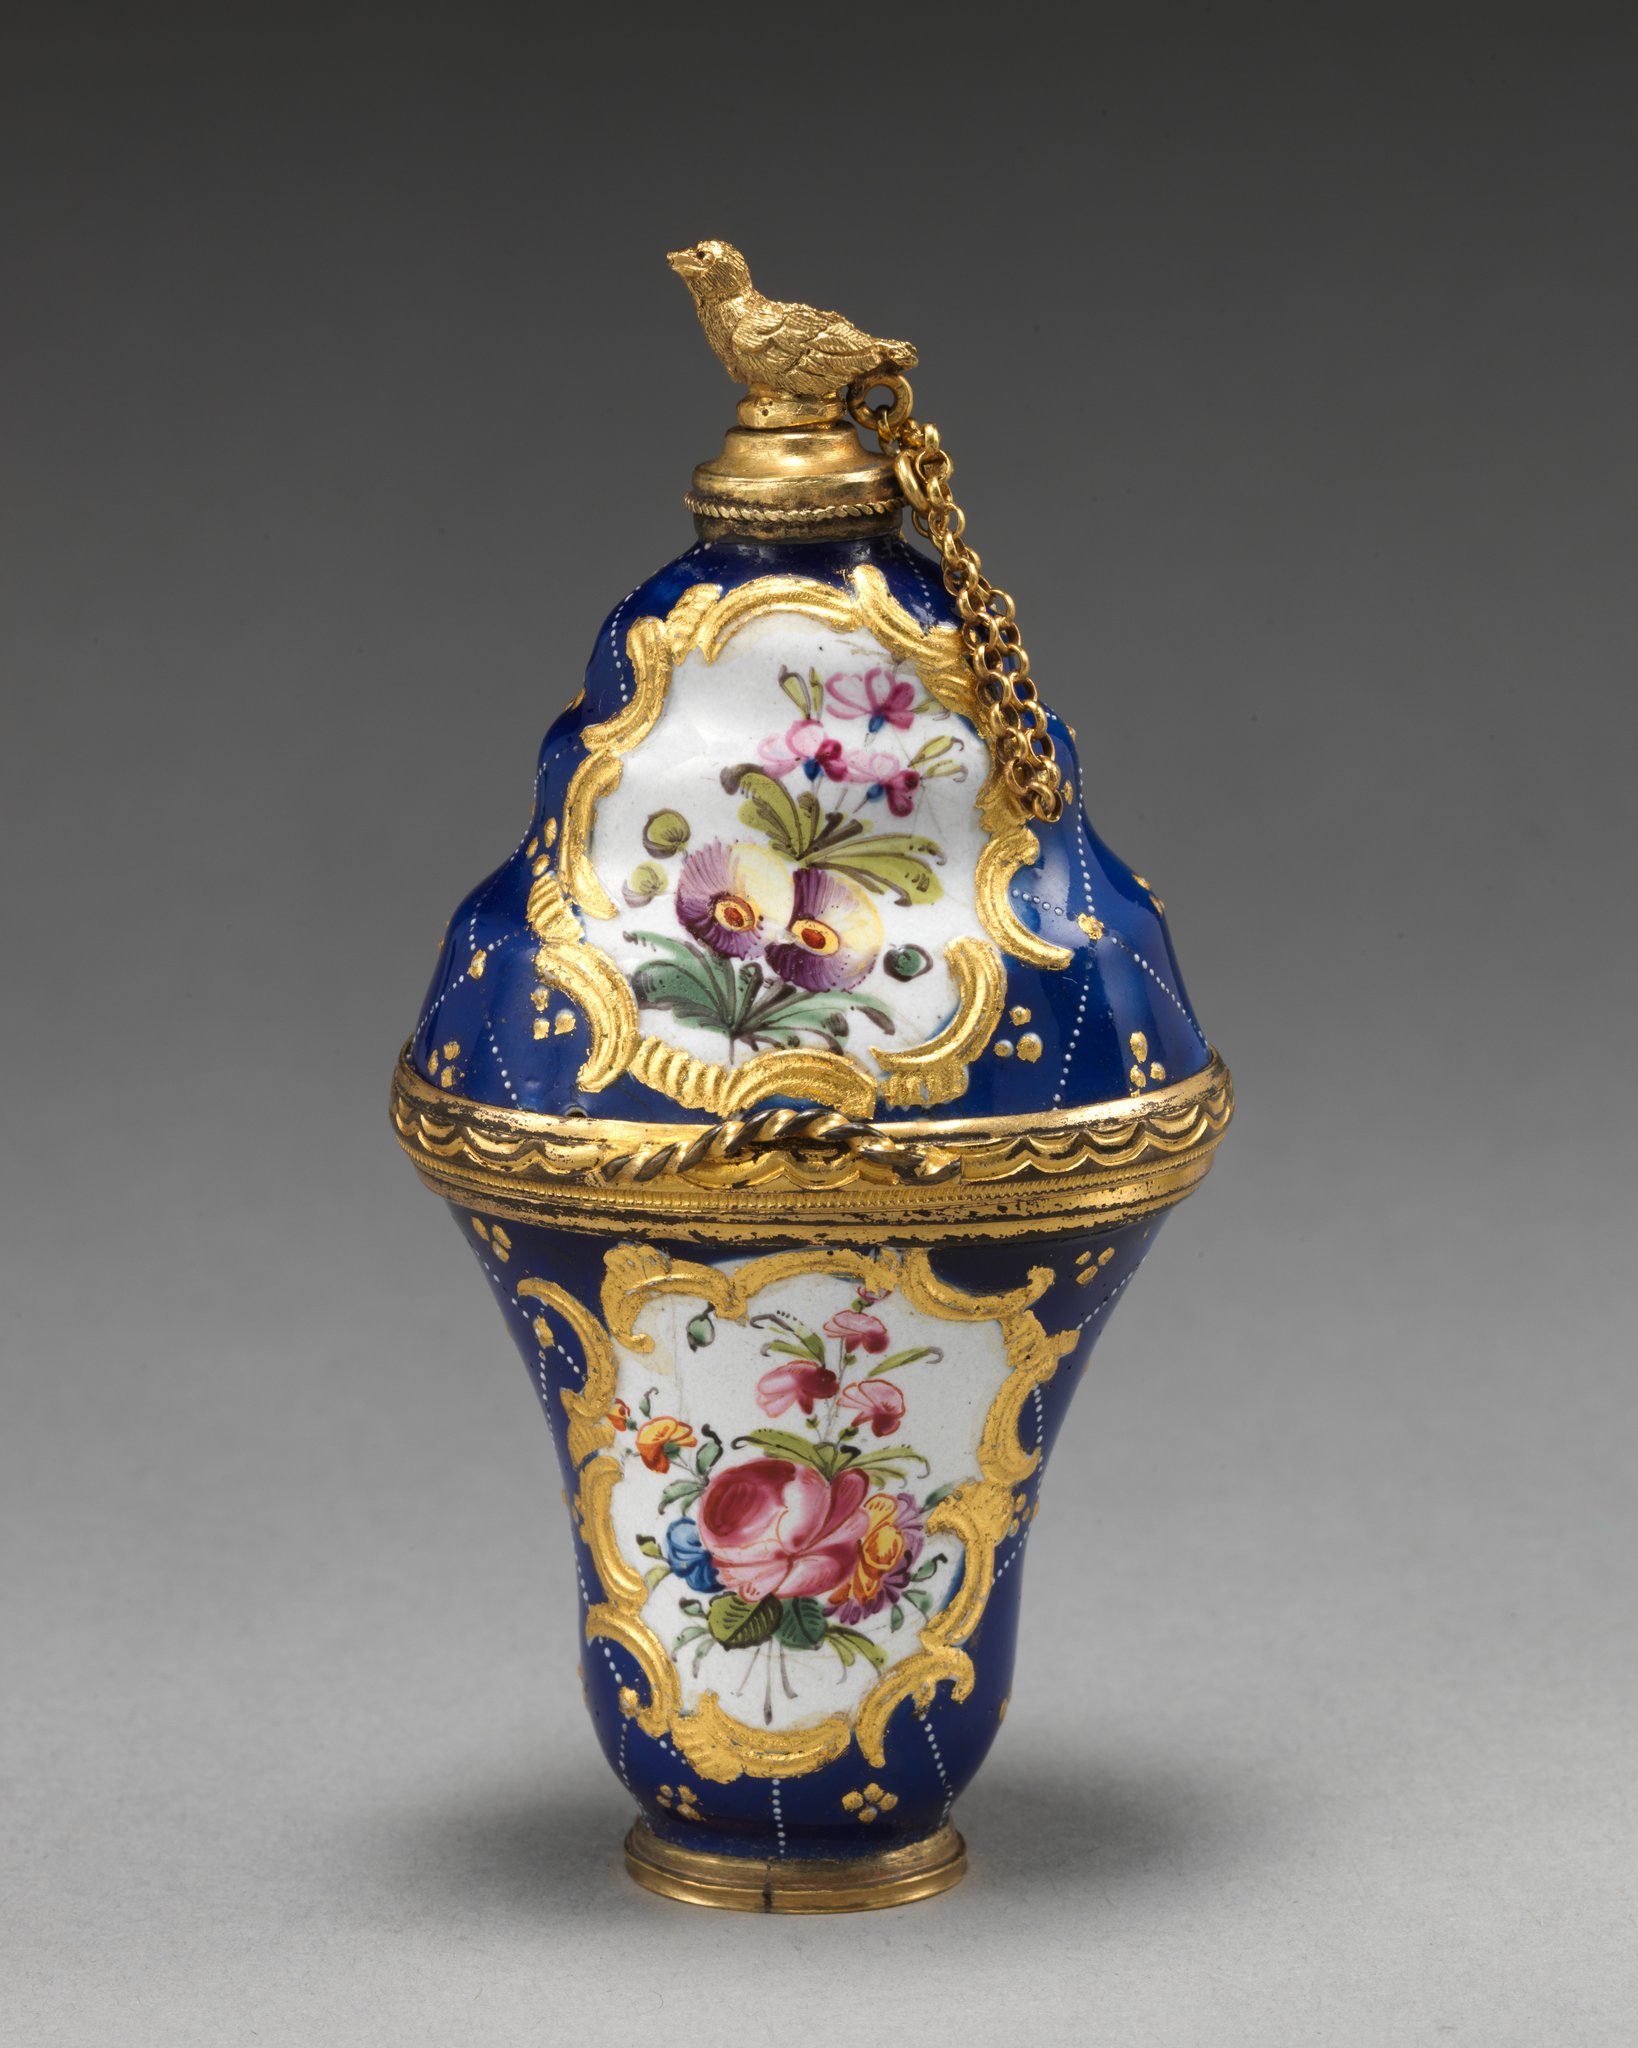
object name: scent bottle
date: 1765-1770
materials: copper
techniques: enamel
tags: flowers